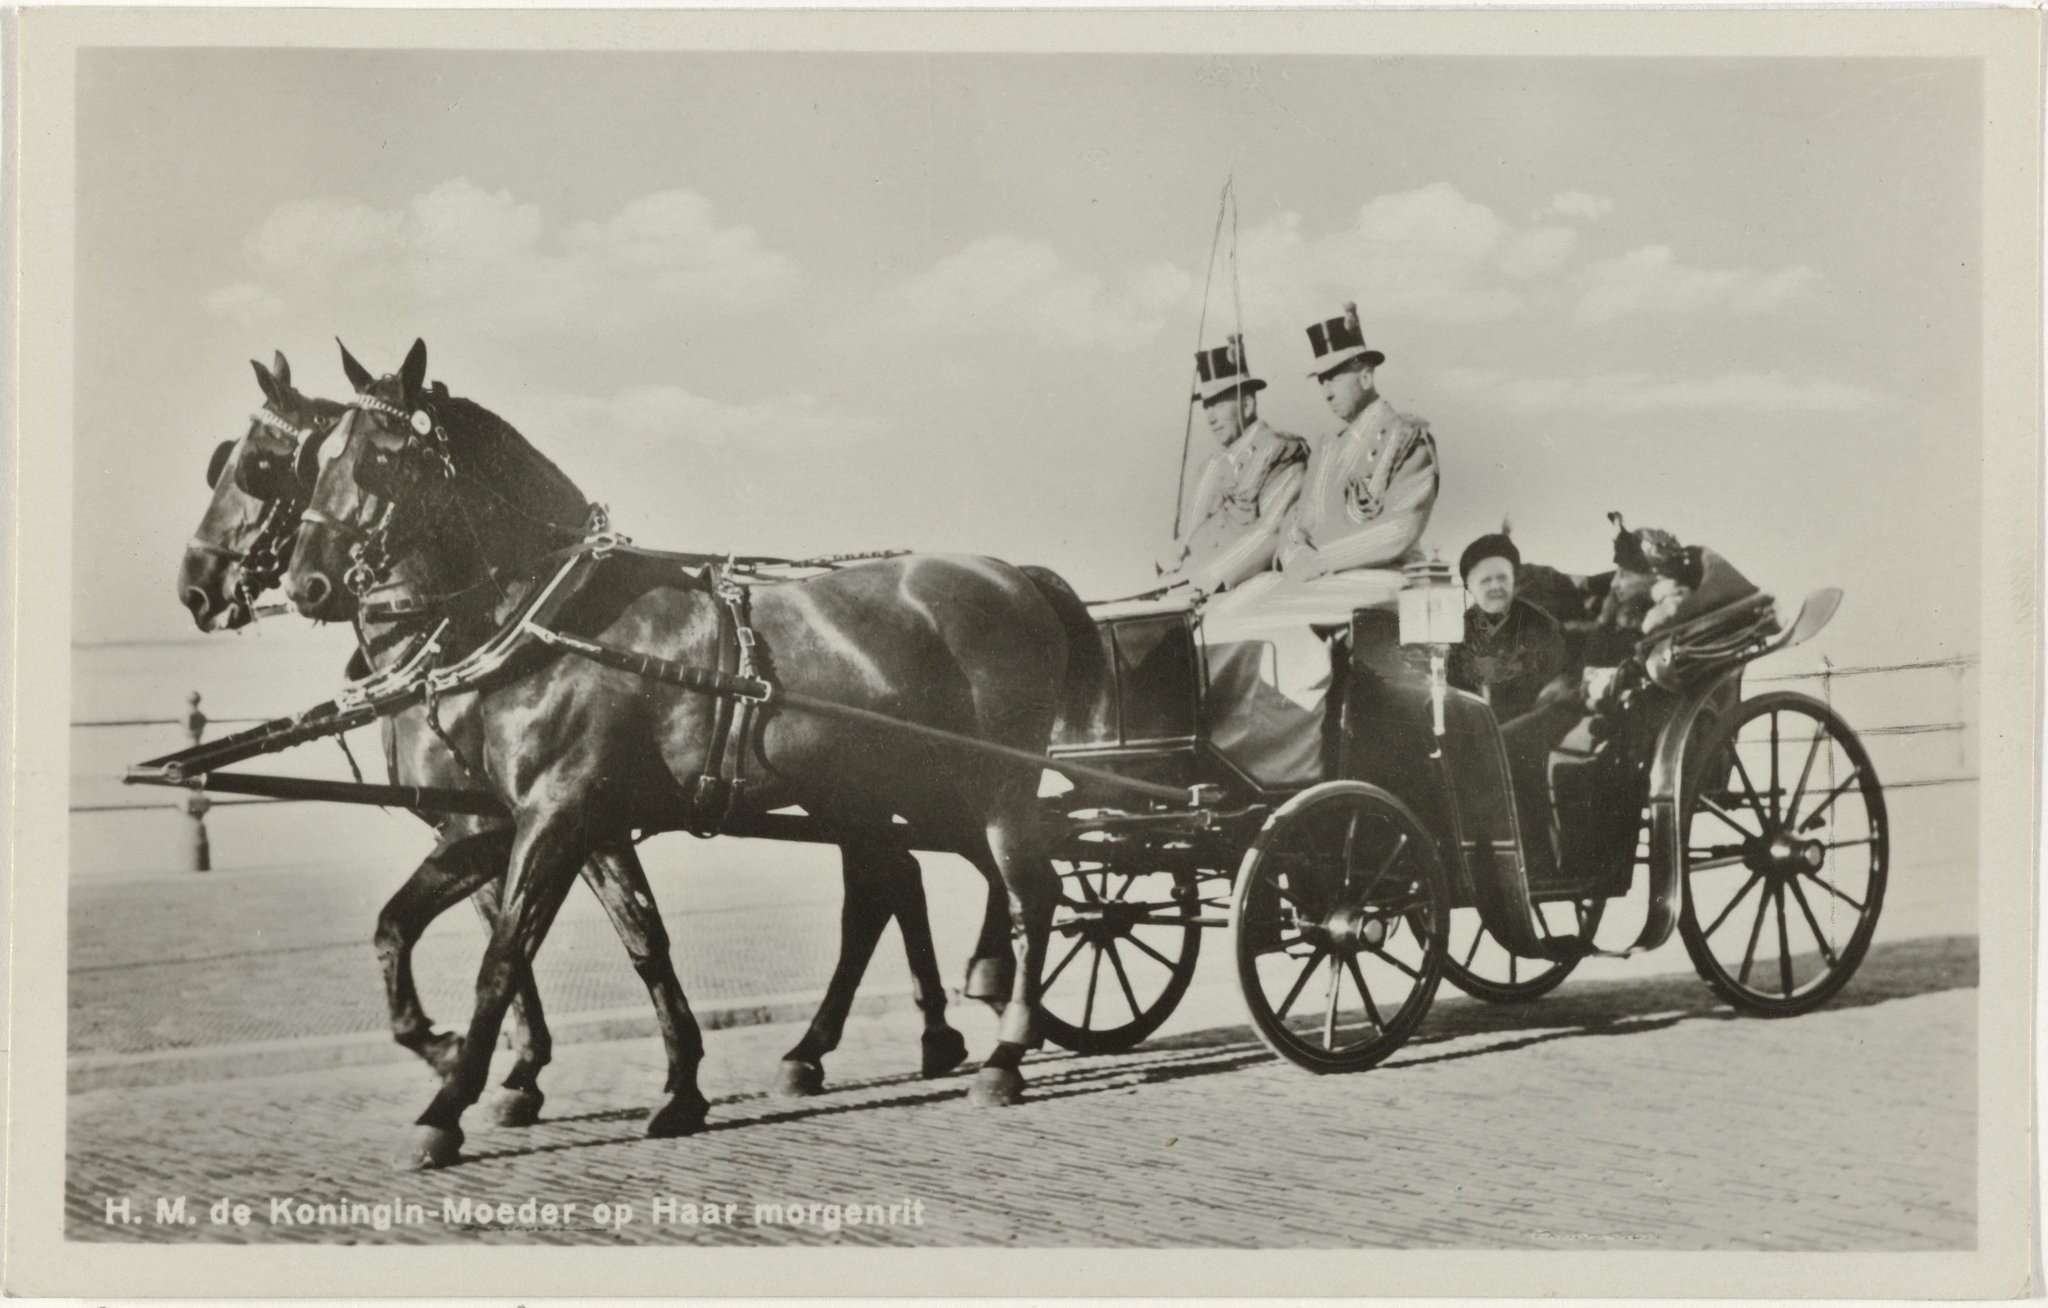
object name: photograph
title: Emma, koningin-regentes der Nederlanden, op haar morgenrit in een rijtuig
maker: Anonymous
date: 1925-1934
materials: photographic support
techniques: photography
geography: the hague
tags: the hague, emma (queen consort of the netherlands), animal traction, animal-drawn vehicle (carriage etc.)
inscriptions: inscription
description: De hier vermelde titel verwijst naar de hoogst verkregen titel van de geportretteerde, niet per se naar de titel die de geportretteerde op deze voorstelling draagt.